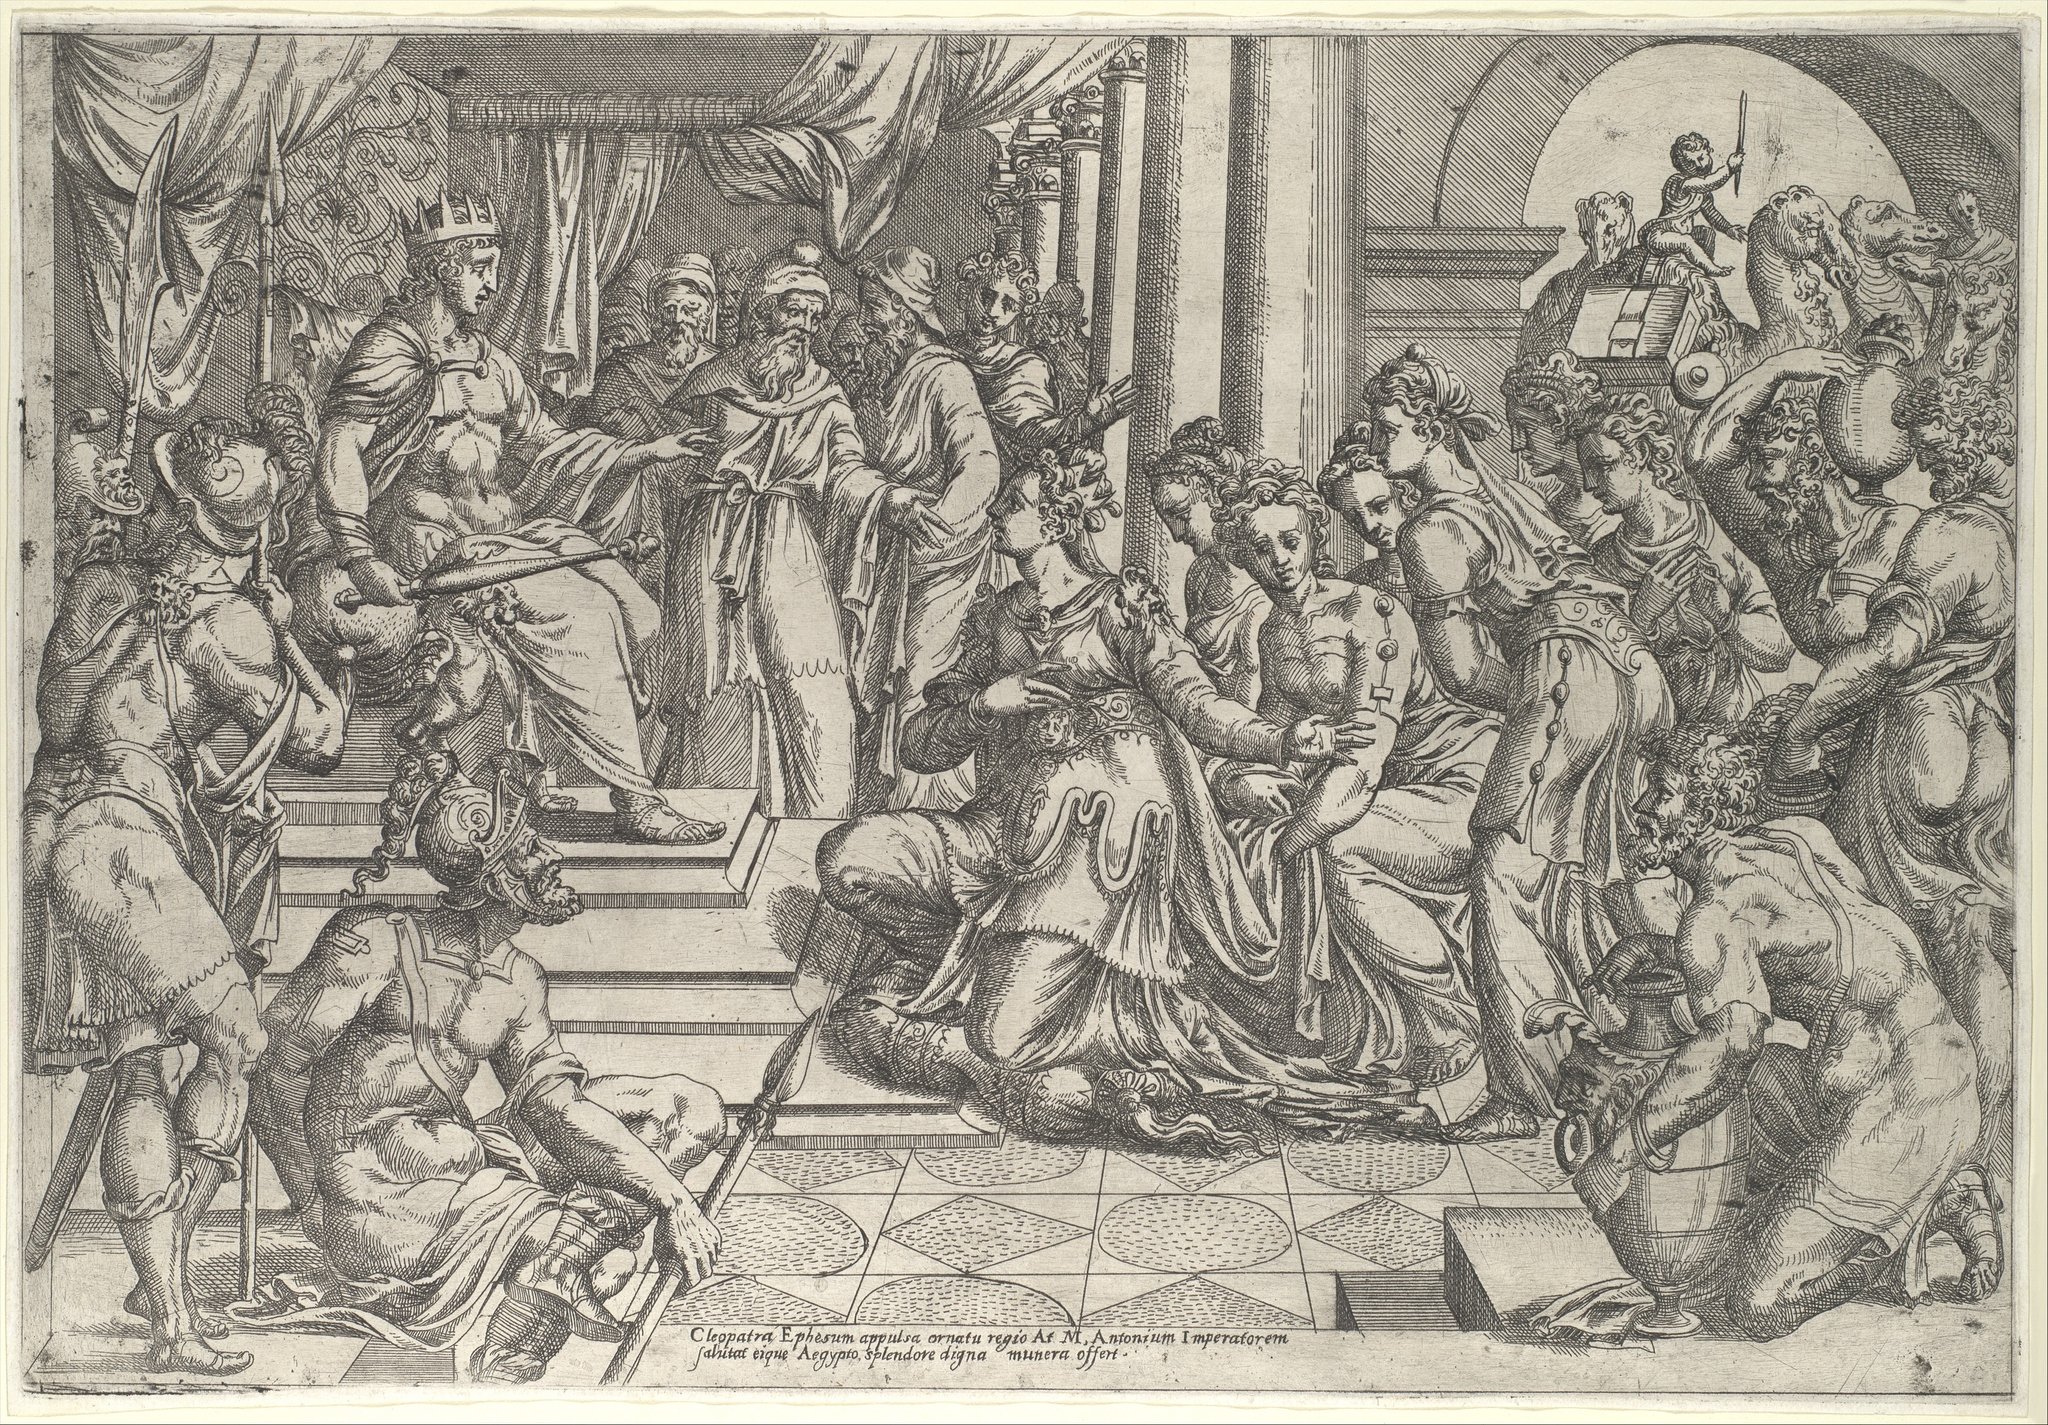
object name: print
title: Solomon and the Queen of Sheba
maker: anonymous, french, school of fontainebleau, 16th century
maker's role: artist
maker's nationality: french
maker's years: 1500-1600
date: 1501-1600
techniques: engraving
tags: weapons,queens